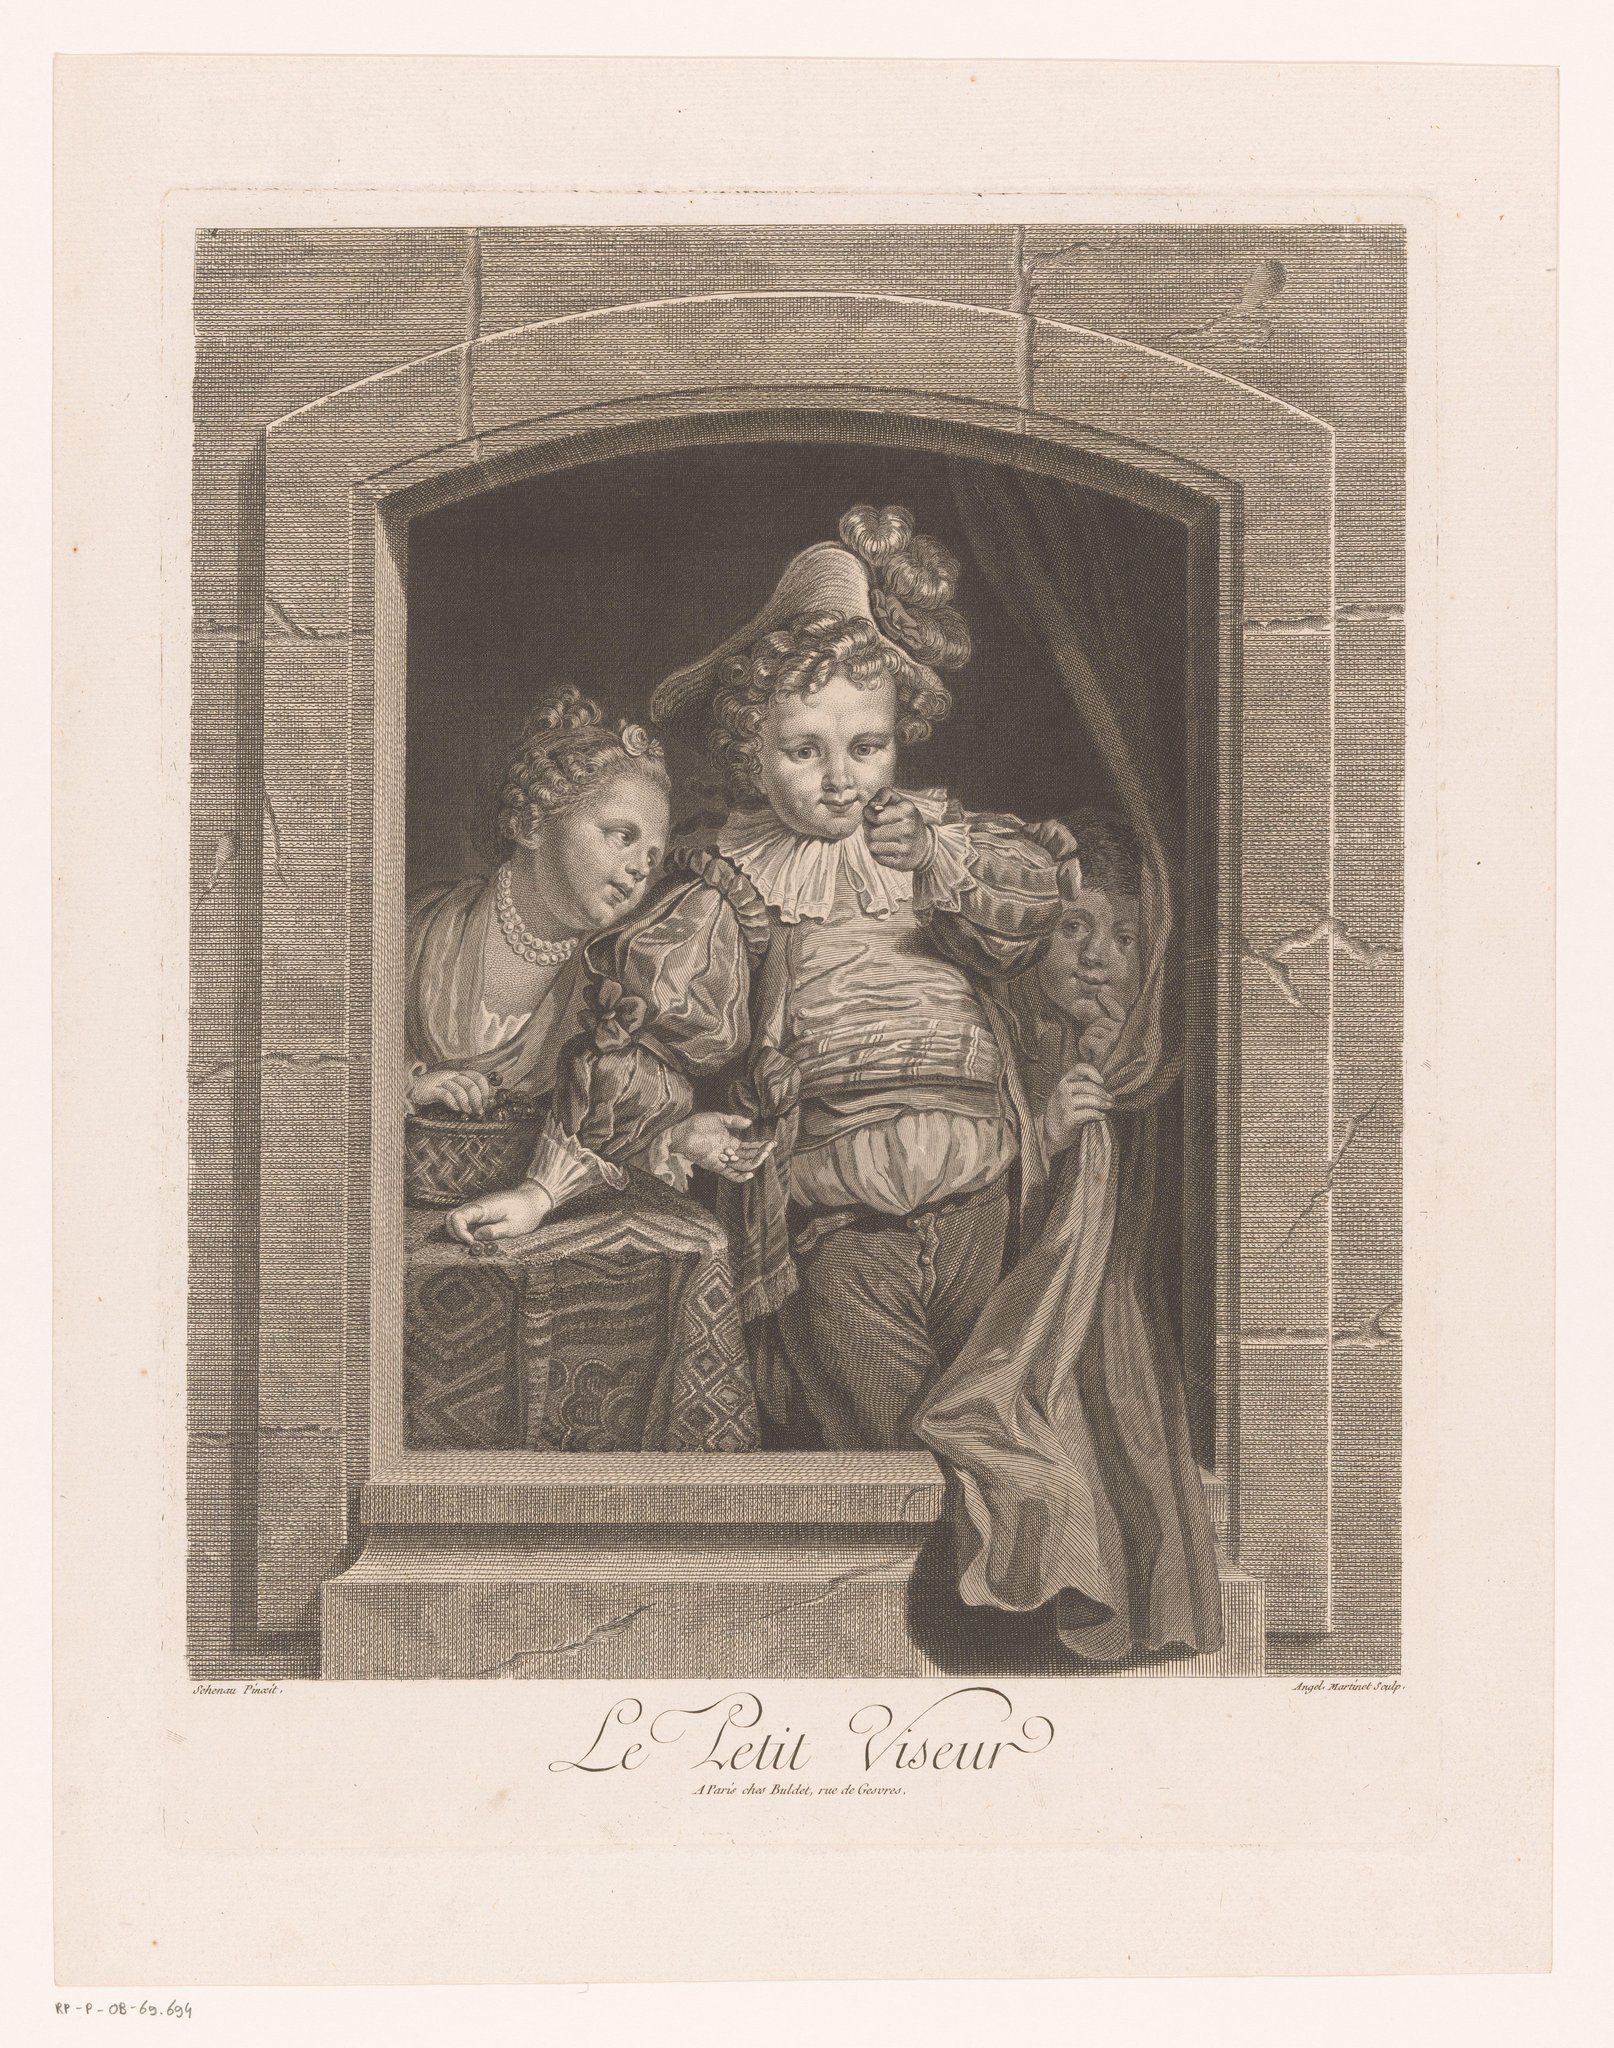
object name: print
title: Drie rijk geklede kinderen met kersen in een venster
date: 1741-1780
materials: paper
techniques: engraving, etching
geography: paris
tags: child, human figure at (open) window, seen from outside, fruits: cherry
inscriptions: collector's mark: Lugt 2228